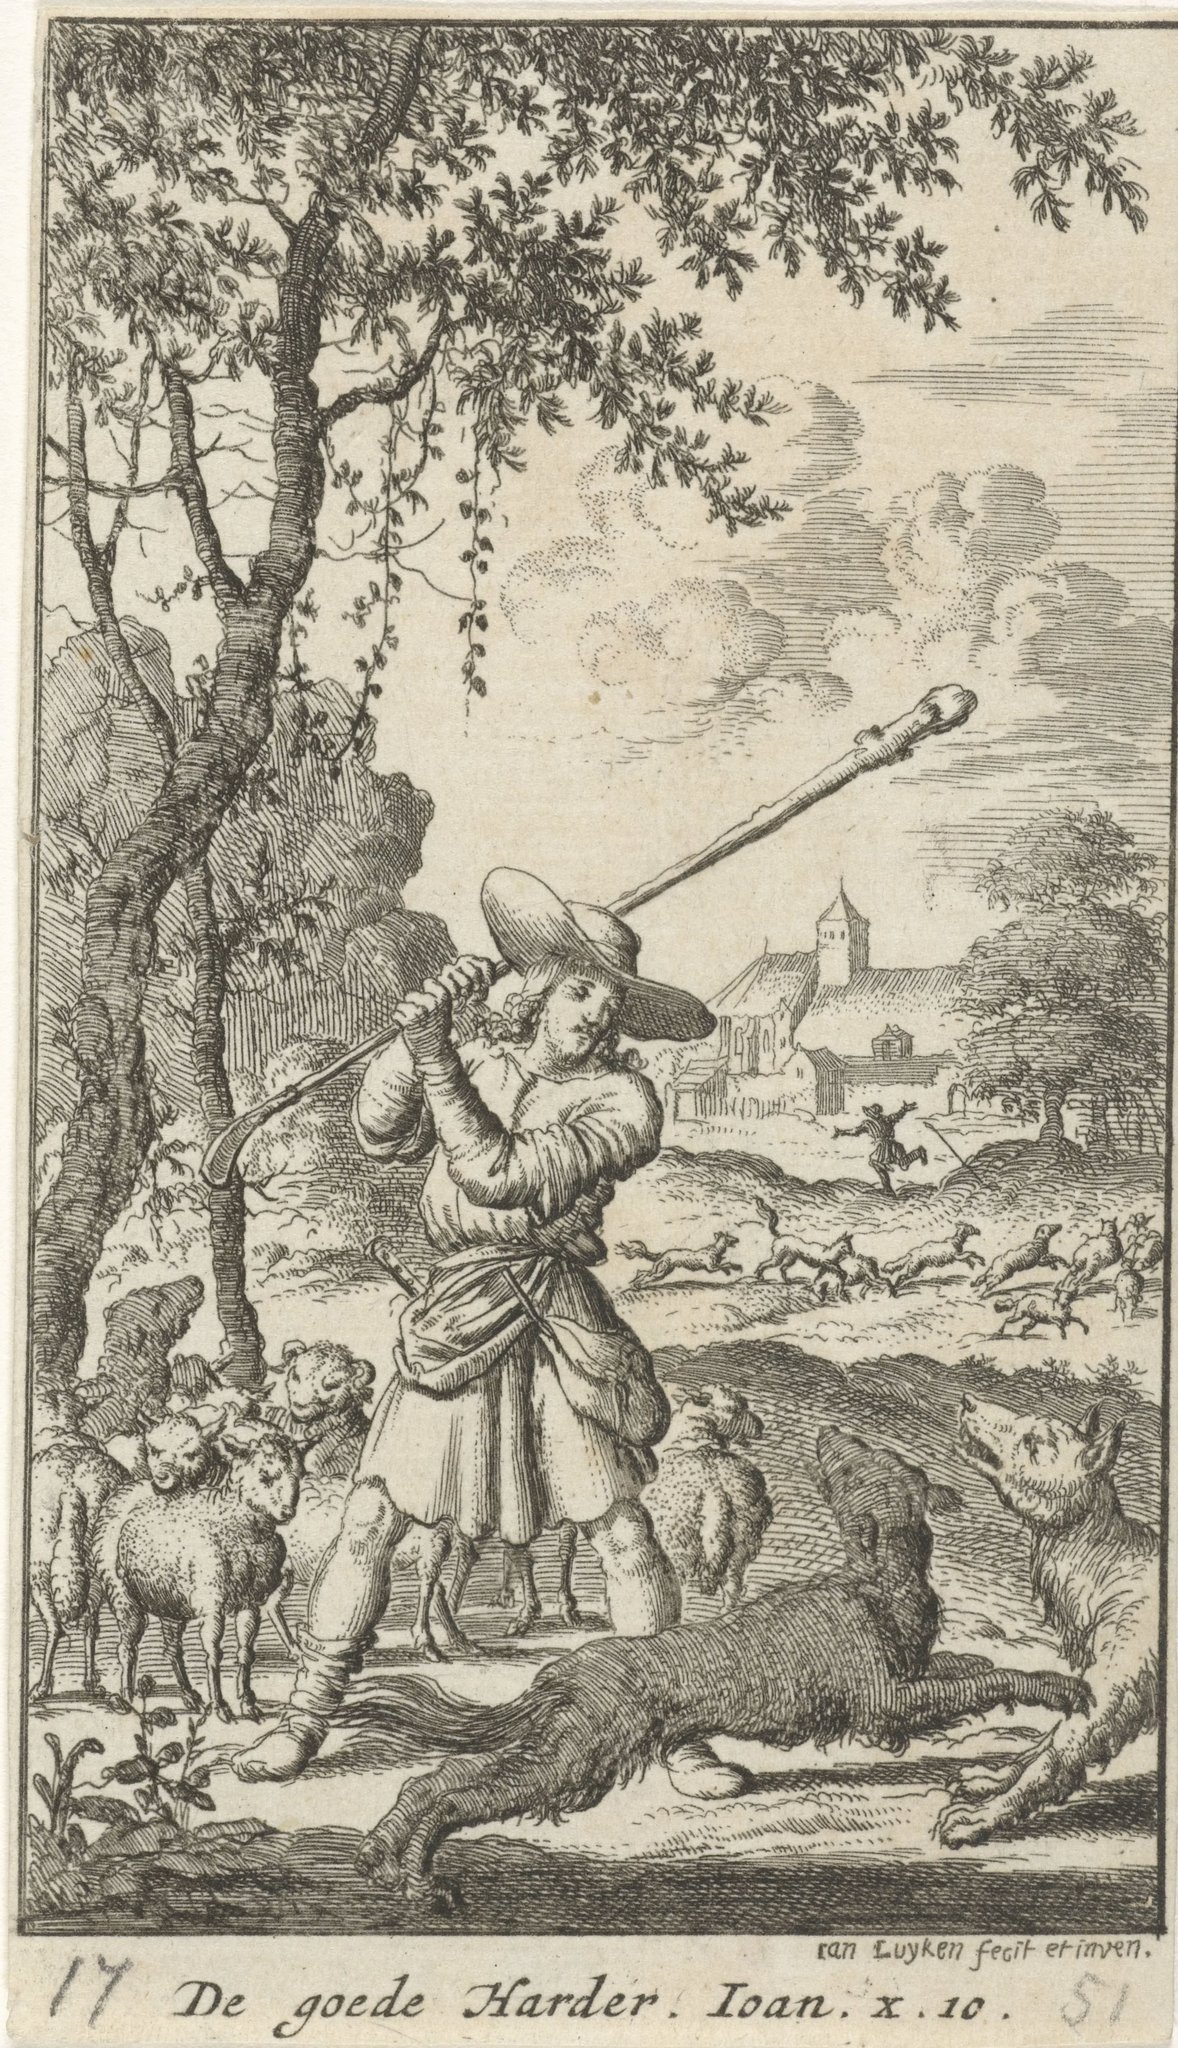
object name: print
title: Vierentwintig scènes uit het Nieuwe Testament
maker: jan luyken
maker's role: draughtsman, print maker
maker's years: 1649-1712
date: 1681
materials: paper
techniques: etching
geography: amsterdam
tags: the good shepherd (christ) defending his sheep against wolves; 'i am the good shepherd' (john 10:1-16)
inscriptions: collector's mark: Lugt 240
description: Twintig prenten van deze serie (waaronder de hier besproken prent) verschenen mogelijk voor het eerst in: Het Nieuwe Testament ofte alle Boecken des Nieuwen Verbondts onses Heeren Iesu Christi. Amsterdam: Hieronymus Sweerts, Jan ten Hoorn, Jan Bouman en Daniel van den Dalen, 1681. De complete vierentwintigdelige serie prenten is opgenomen in: Het Nieuwe Testament ofte alle Boecken des Nieuwen Verbondts onses Heeren Iesu Christi. Dordrecht: Pieter en Jacob Keur, 172X (niet voor 1727). De prenten werden, hetzij alle tezamen, hetzij gedeeltelijk, veel gebruikt tot versiering van Nieuwe Testamenten en verschenen tevens in kopie.